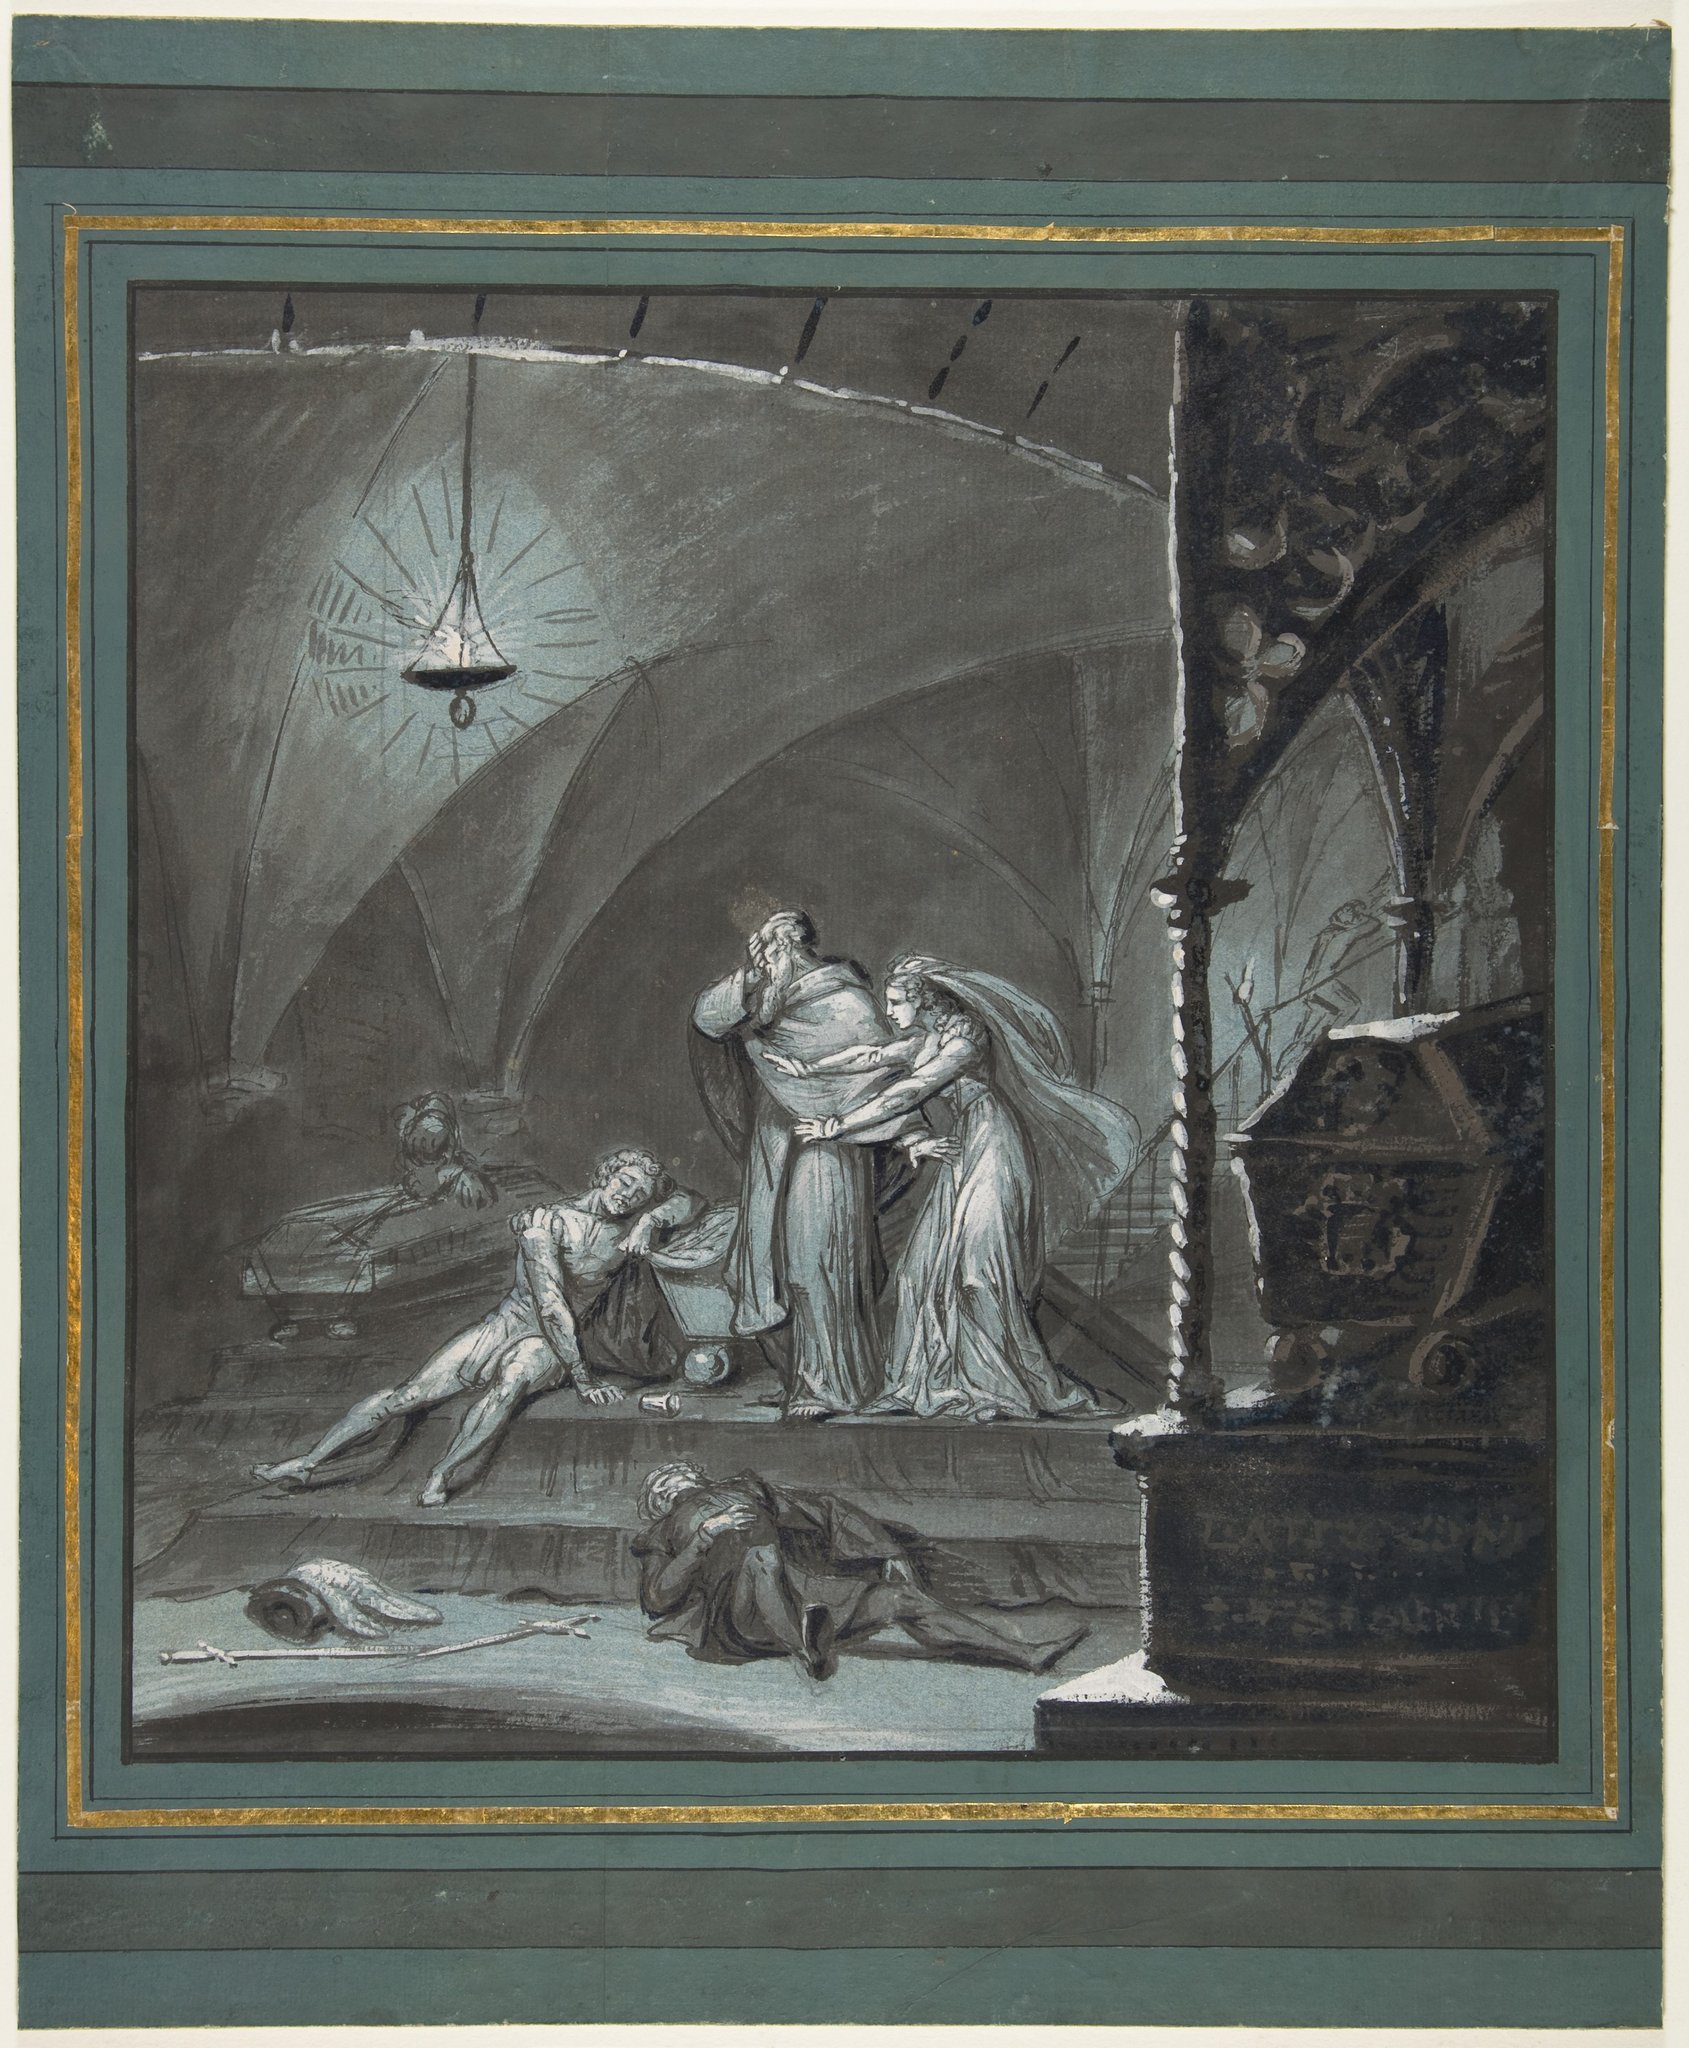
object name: drawing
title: Friar Lawrence and Juliet Discover the Bodies of Romeo and Paris (Romeo and Juliet, Act 5, scene 3)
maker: anonymous, french, 19th century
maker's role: artist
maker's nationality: french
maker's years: 1800-1900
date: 1801-1900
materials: gouache, ink, paper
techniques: brush, pen, wash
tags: shakespeare,men,women